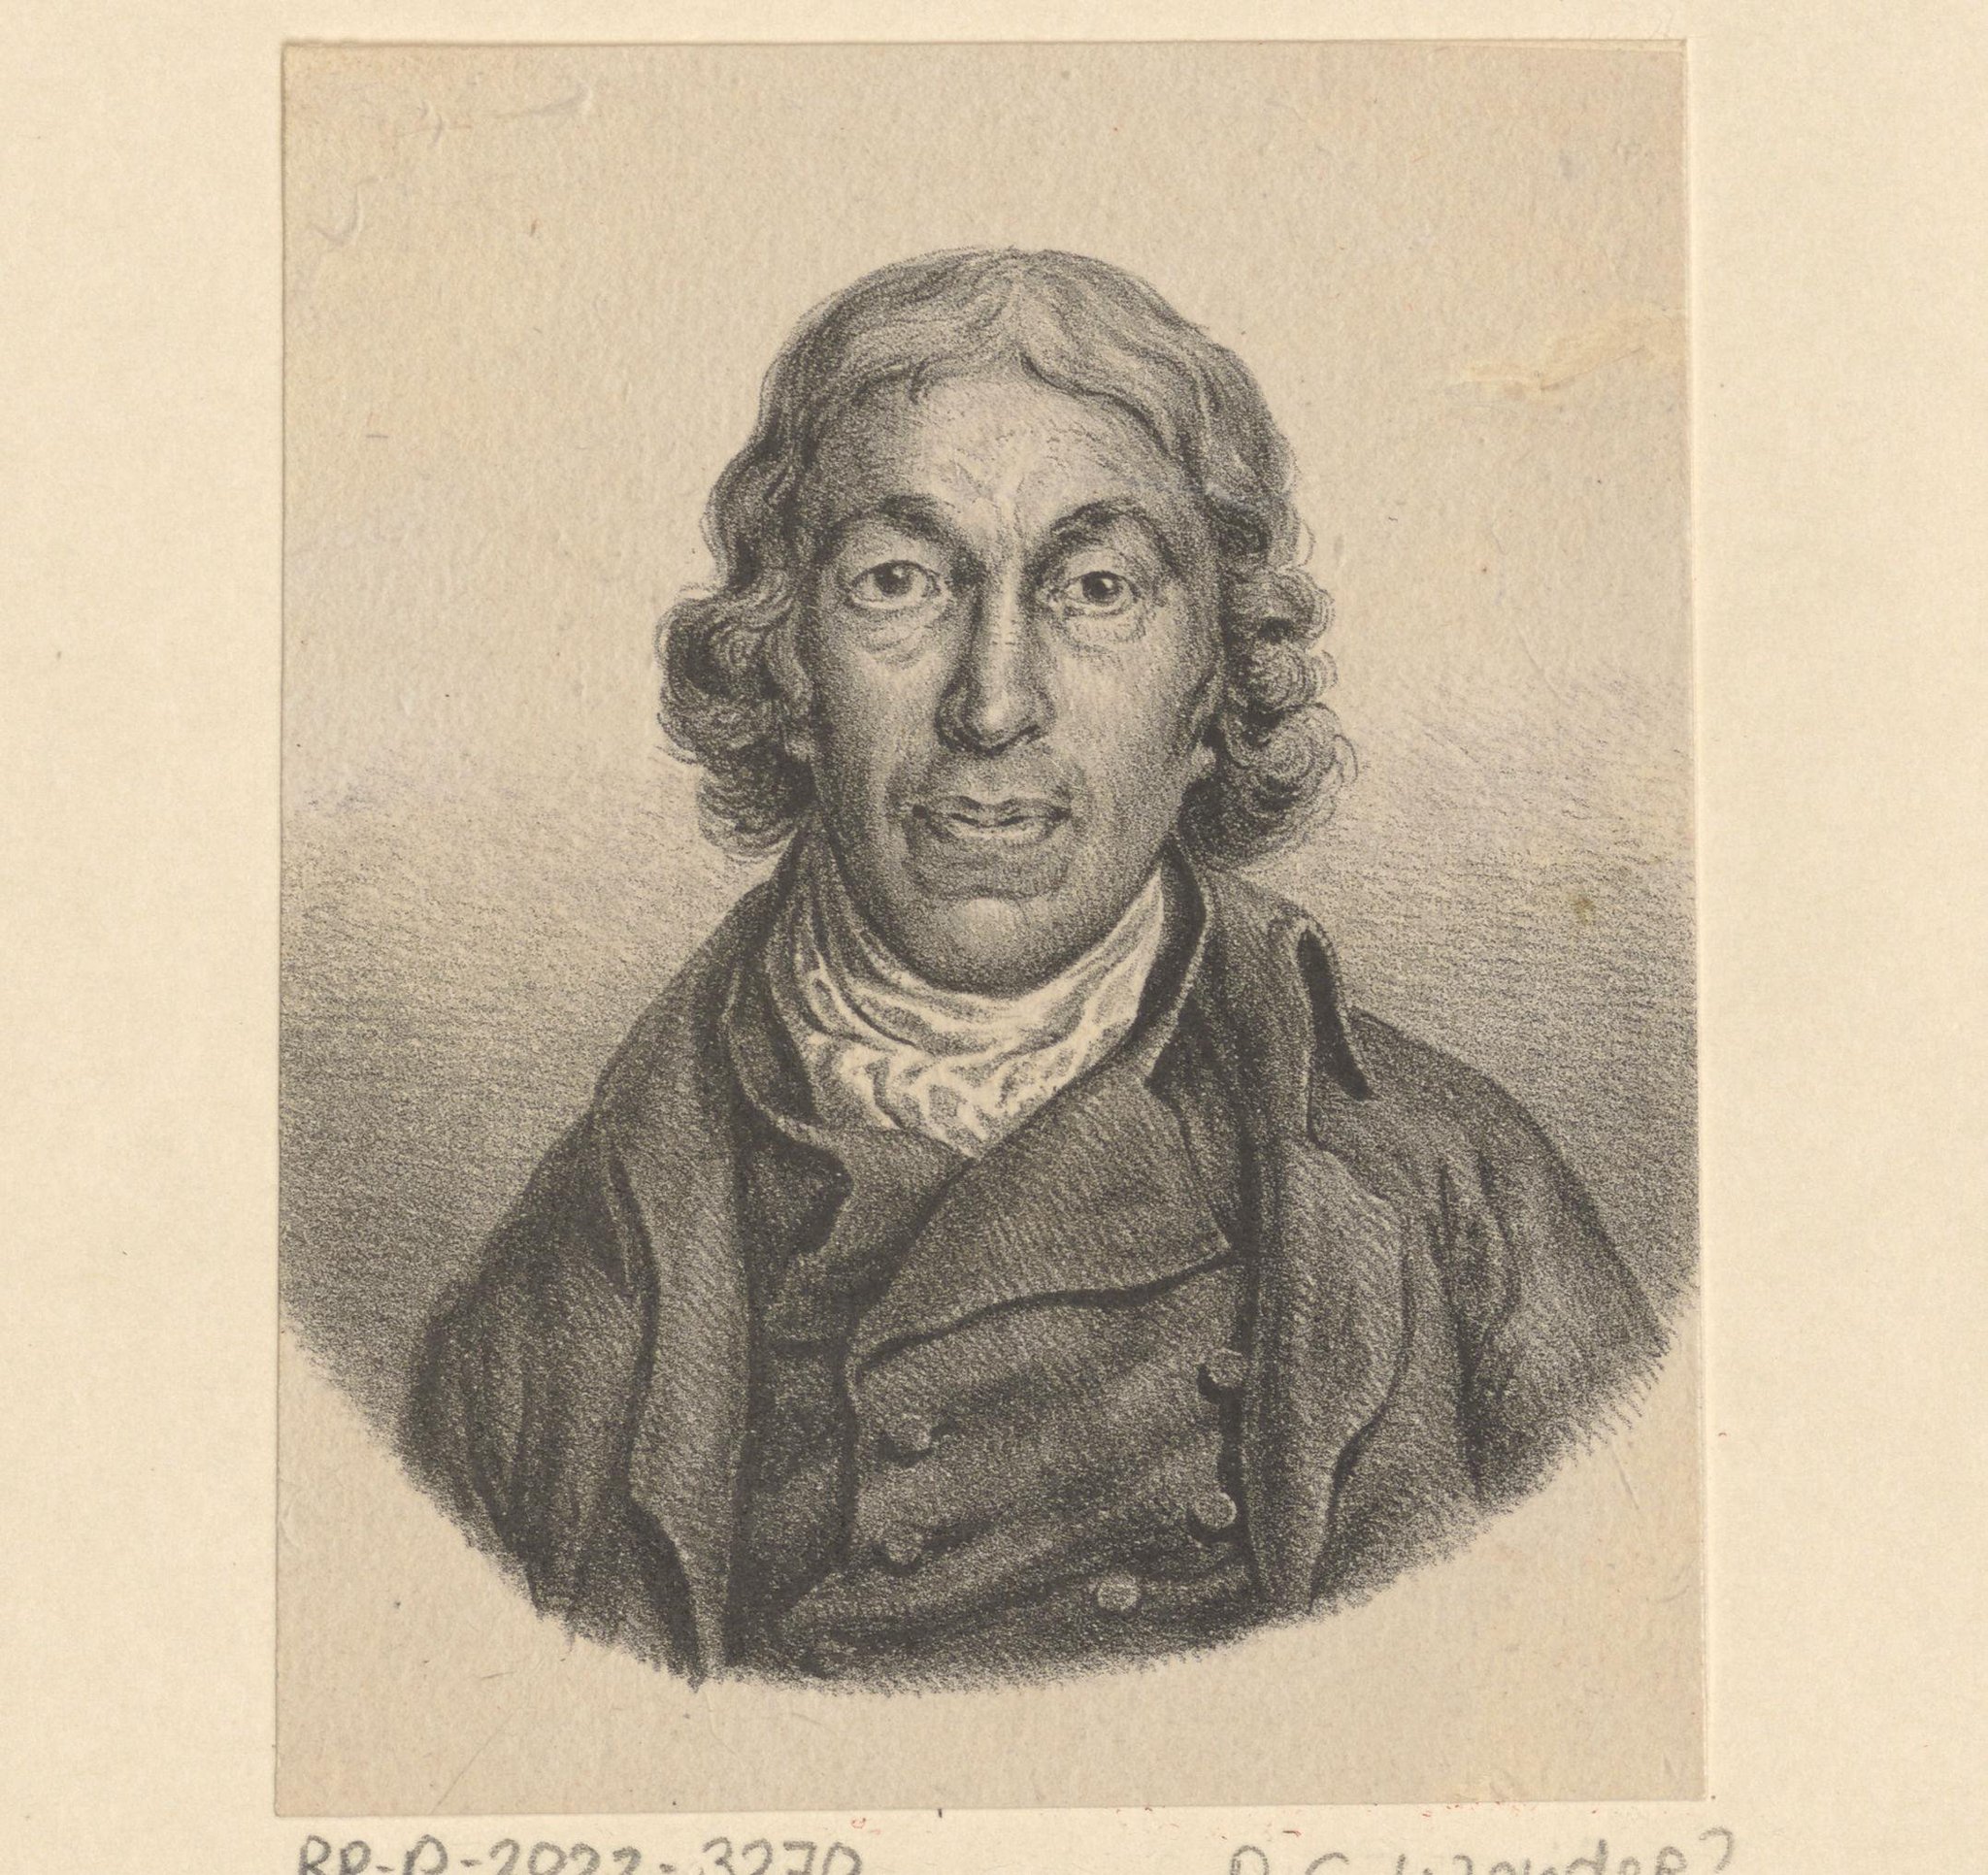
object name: print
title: Portret van Jacob van Strij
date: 1824-1880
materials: paper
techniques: lithograph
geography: dordrecht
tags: dordrecht, painter, print maker, draughtsman, jacob van strij, historical persons, portrait, self-portrait of artist